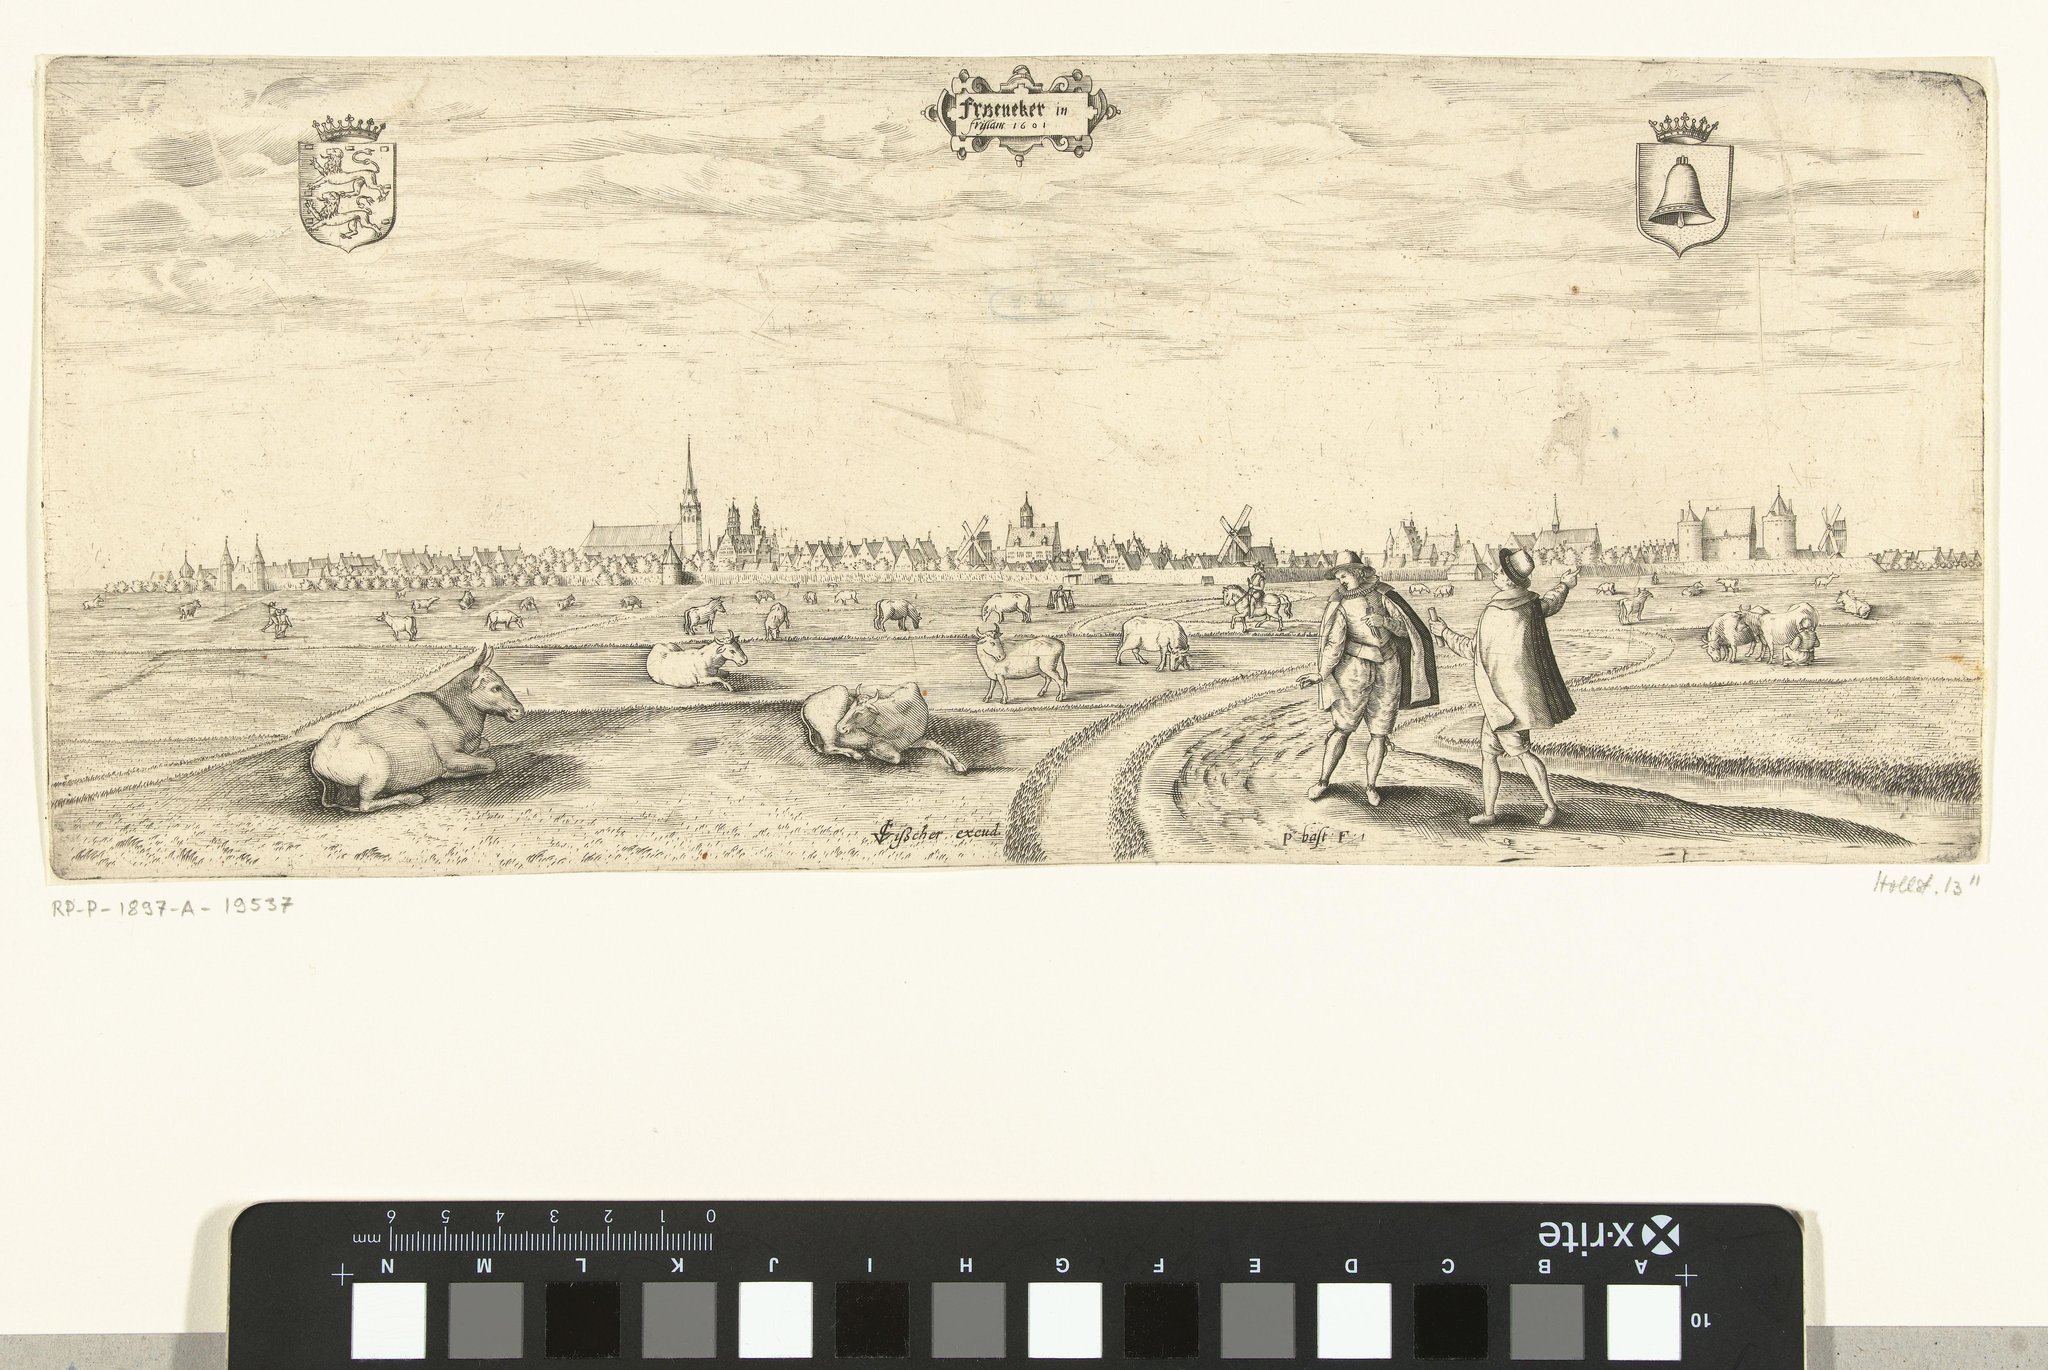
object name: print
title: Gezicht op Franeker in 1601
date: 1601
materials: paper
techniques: engraving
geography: northern netherlands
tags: cattle, clothes, costume (+ men's clothes)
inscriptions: collector's mark: Lugt 2228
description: Op de voorgrond twee mannen, gekleed volgens de mode van ca. 1600, op een landweg, die naar Franeker leidt. Koeien in de wei. Daarachter de stadsmuur van Franeker. In de lucht in 't midden een cartouche met "Franeker in frisiam 1601", links het wapen van Friesland, rechts dat van Franeker.